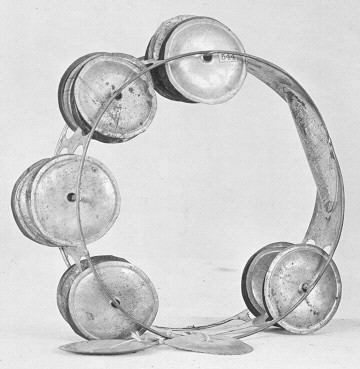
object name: pandeiro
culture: portuguese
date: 1801-1833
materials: tin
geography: portugal